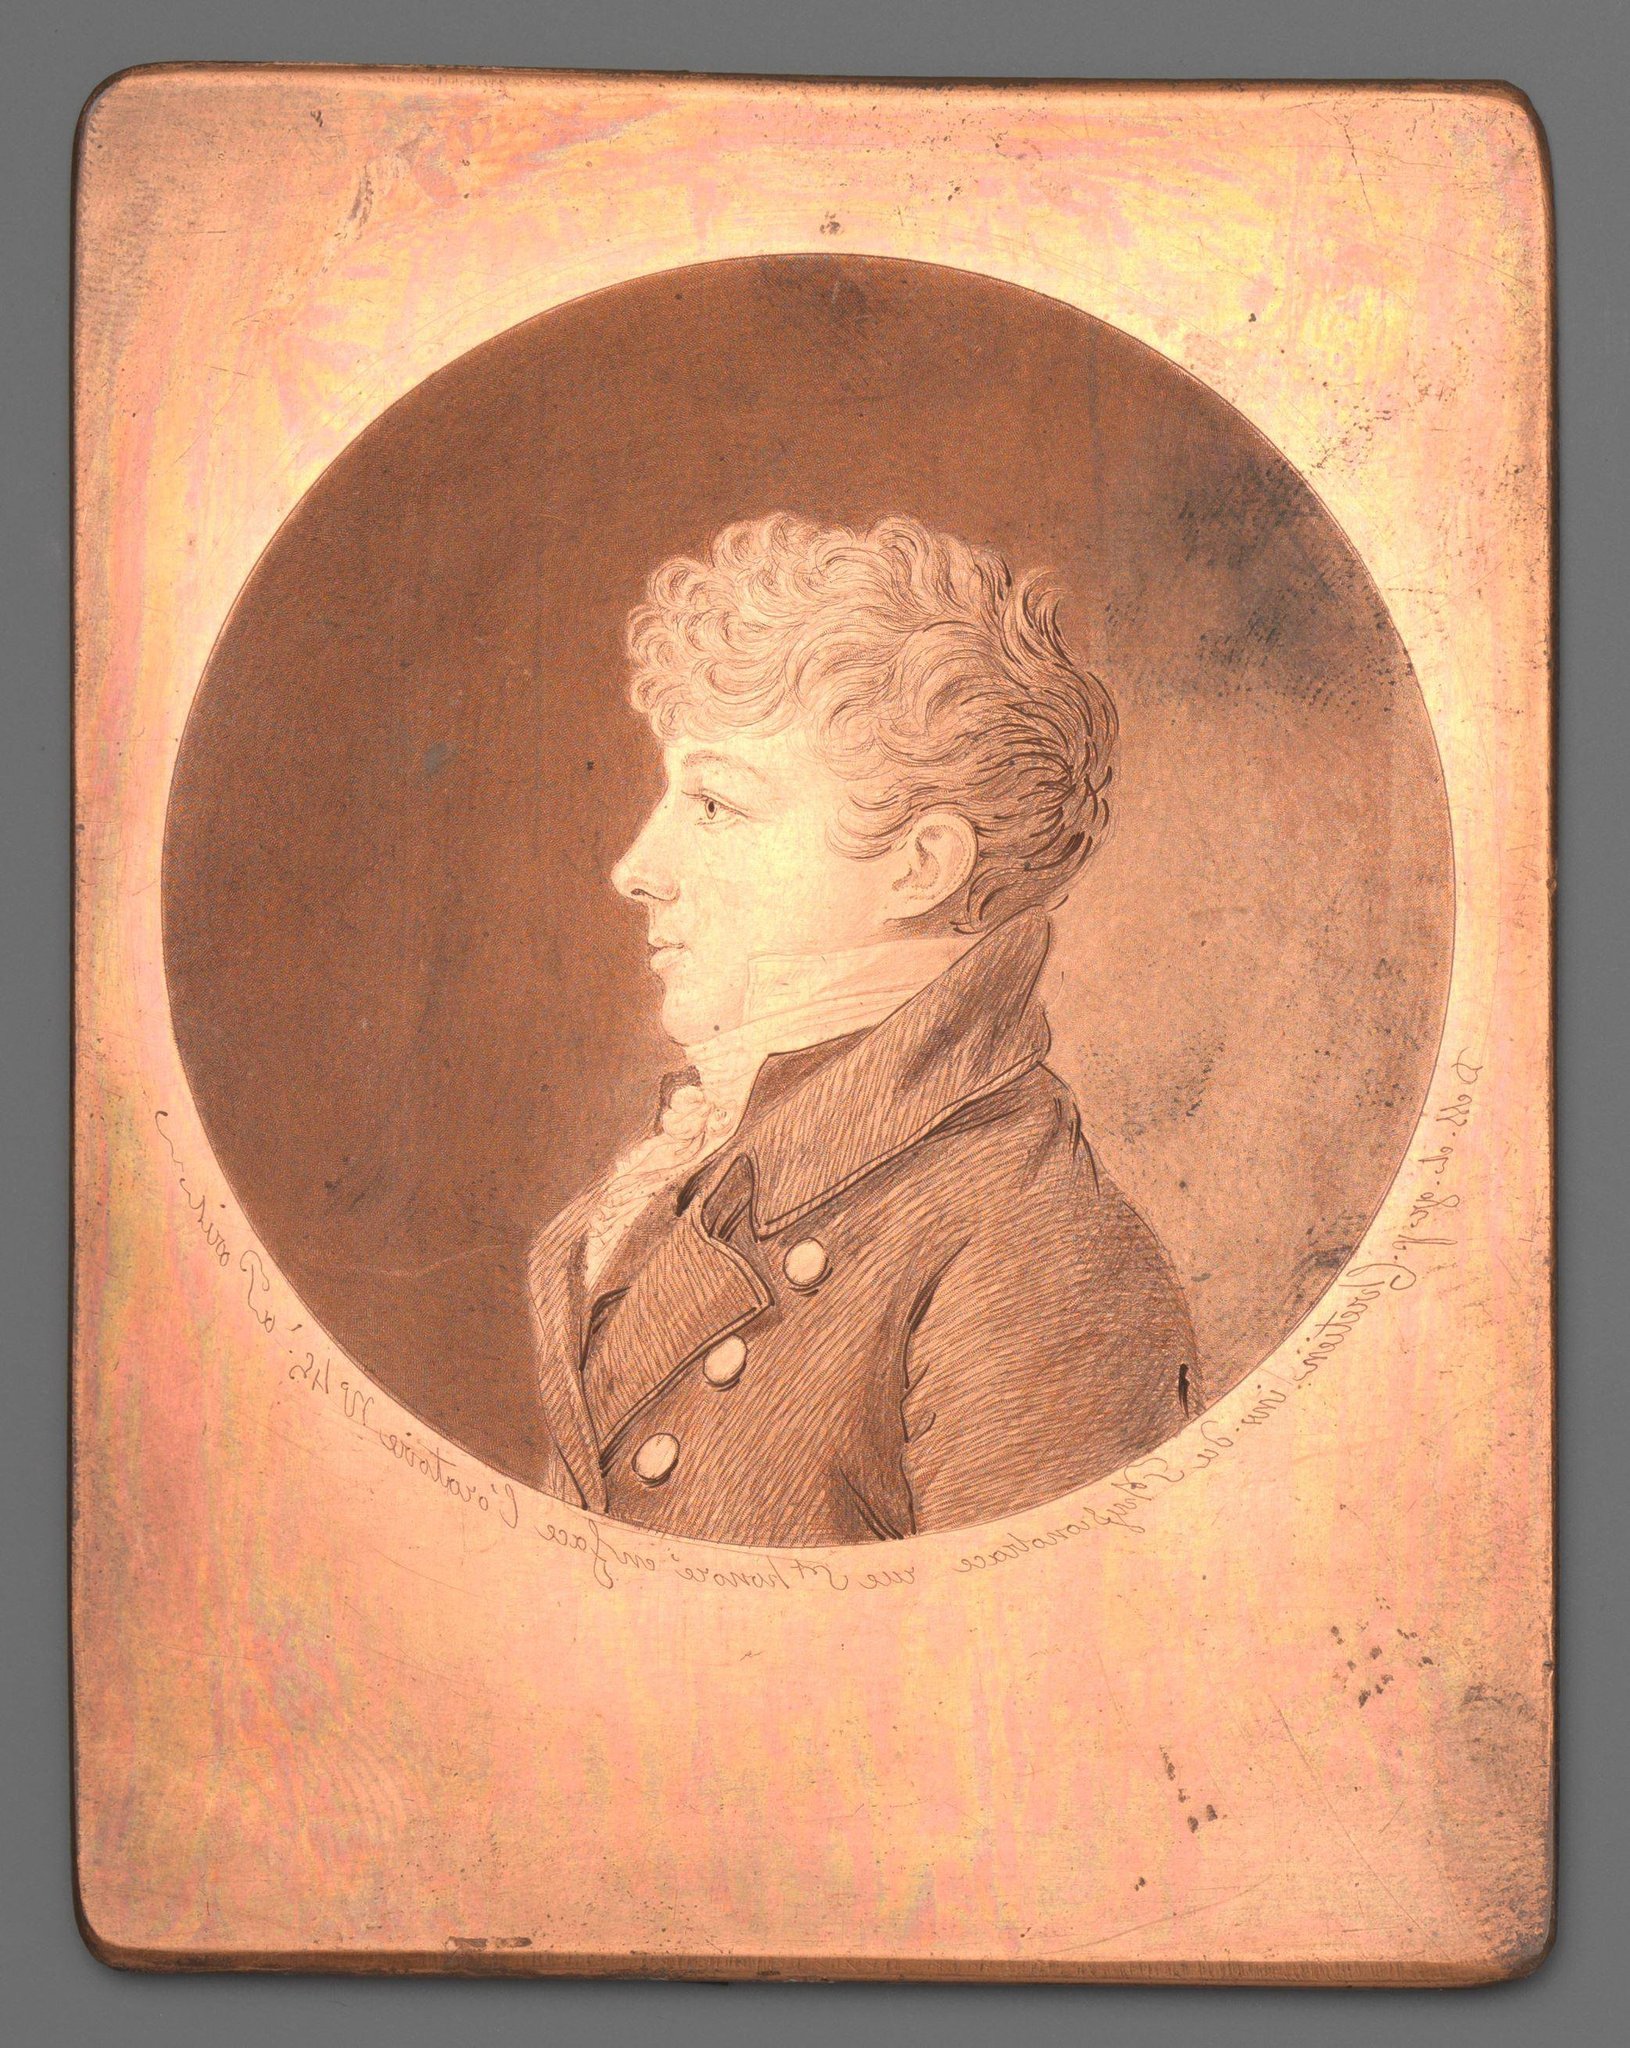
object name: physionotrace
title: Portret van een man, en profil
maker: gilles louis chrétien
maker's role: print maker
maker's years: 1754-1811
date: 1764-1811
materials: copper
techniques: aquatint, etching